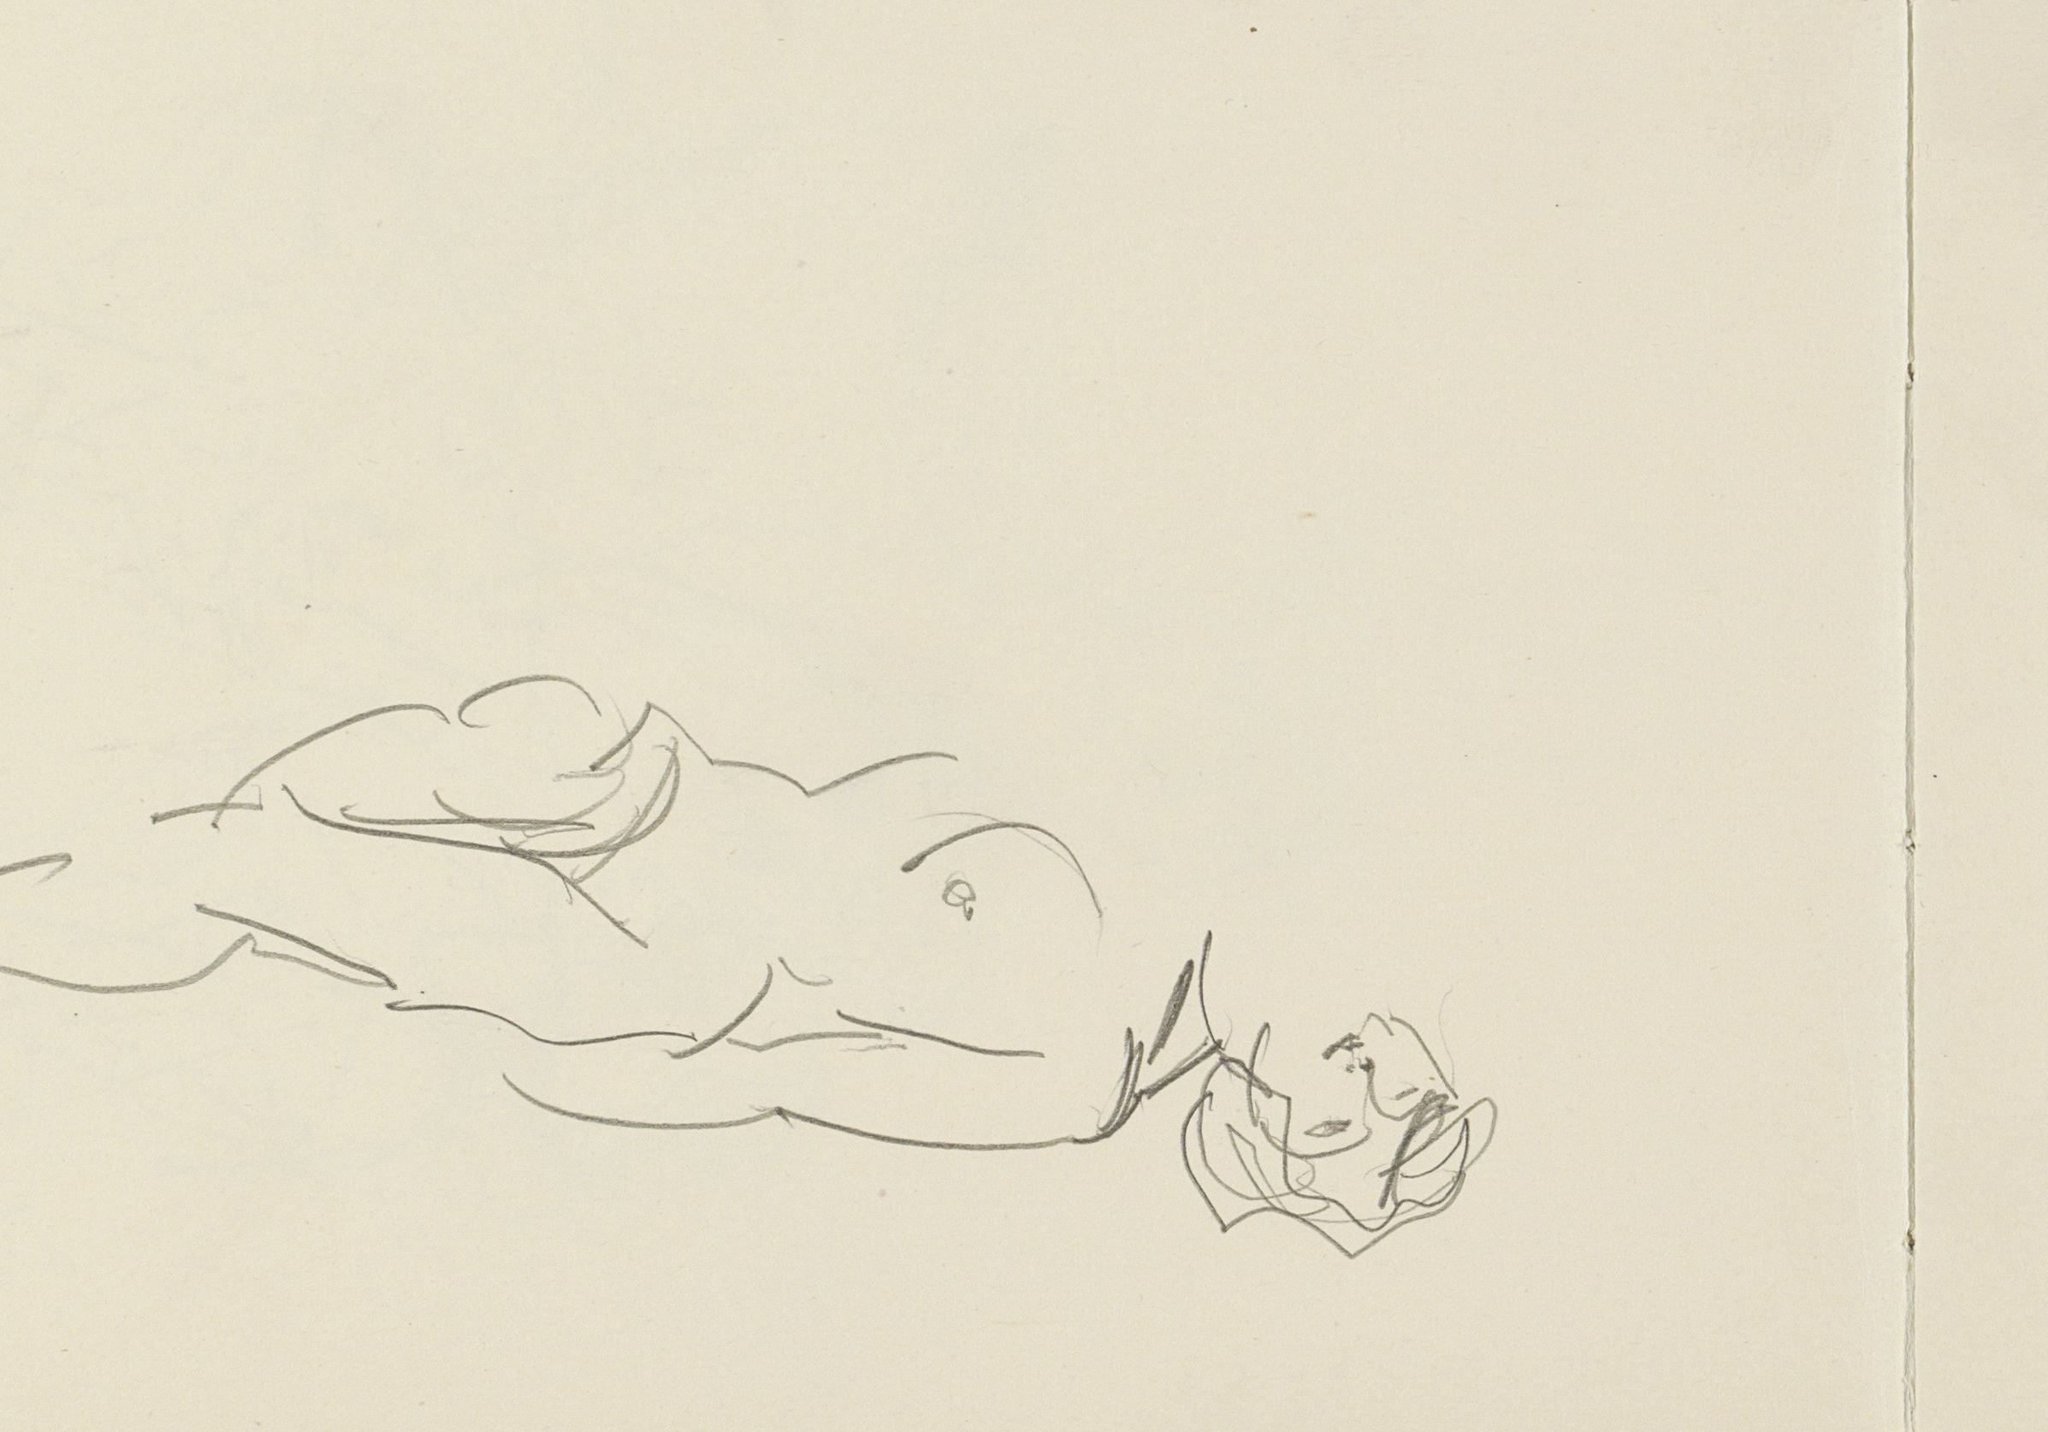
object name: sketchbook leaf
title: Reclining Female Nude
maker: isaac israels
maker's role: draughtsman, painter, print maker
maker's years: 1865-1934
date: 1915-1934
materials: paper, pencil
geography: the hague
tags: the (nude) human figure; 'corpo humano' (ripa) - aa - female human figure (+ lying)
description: Blad 15 verso uit schetsboek XXV met 23 bladen.